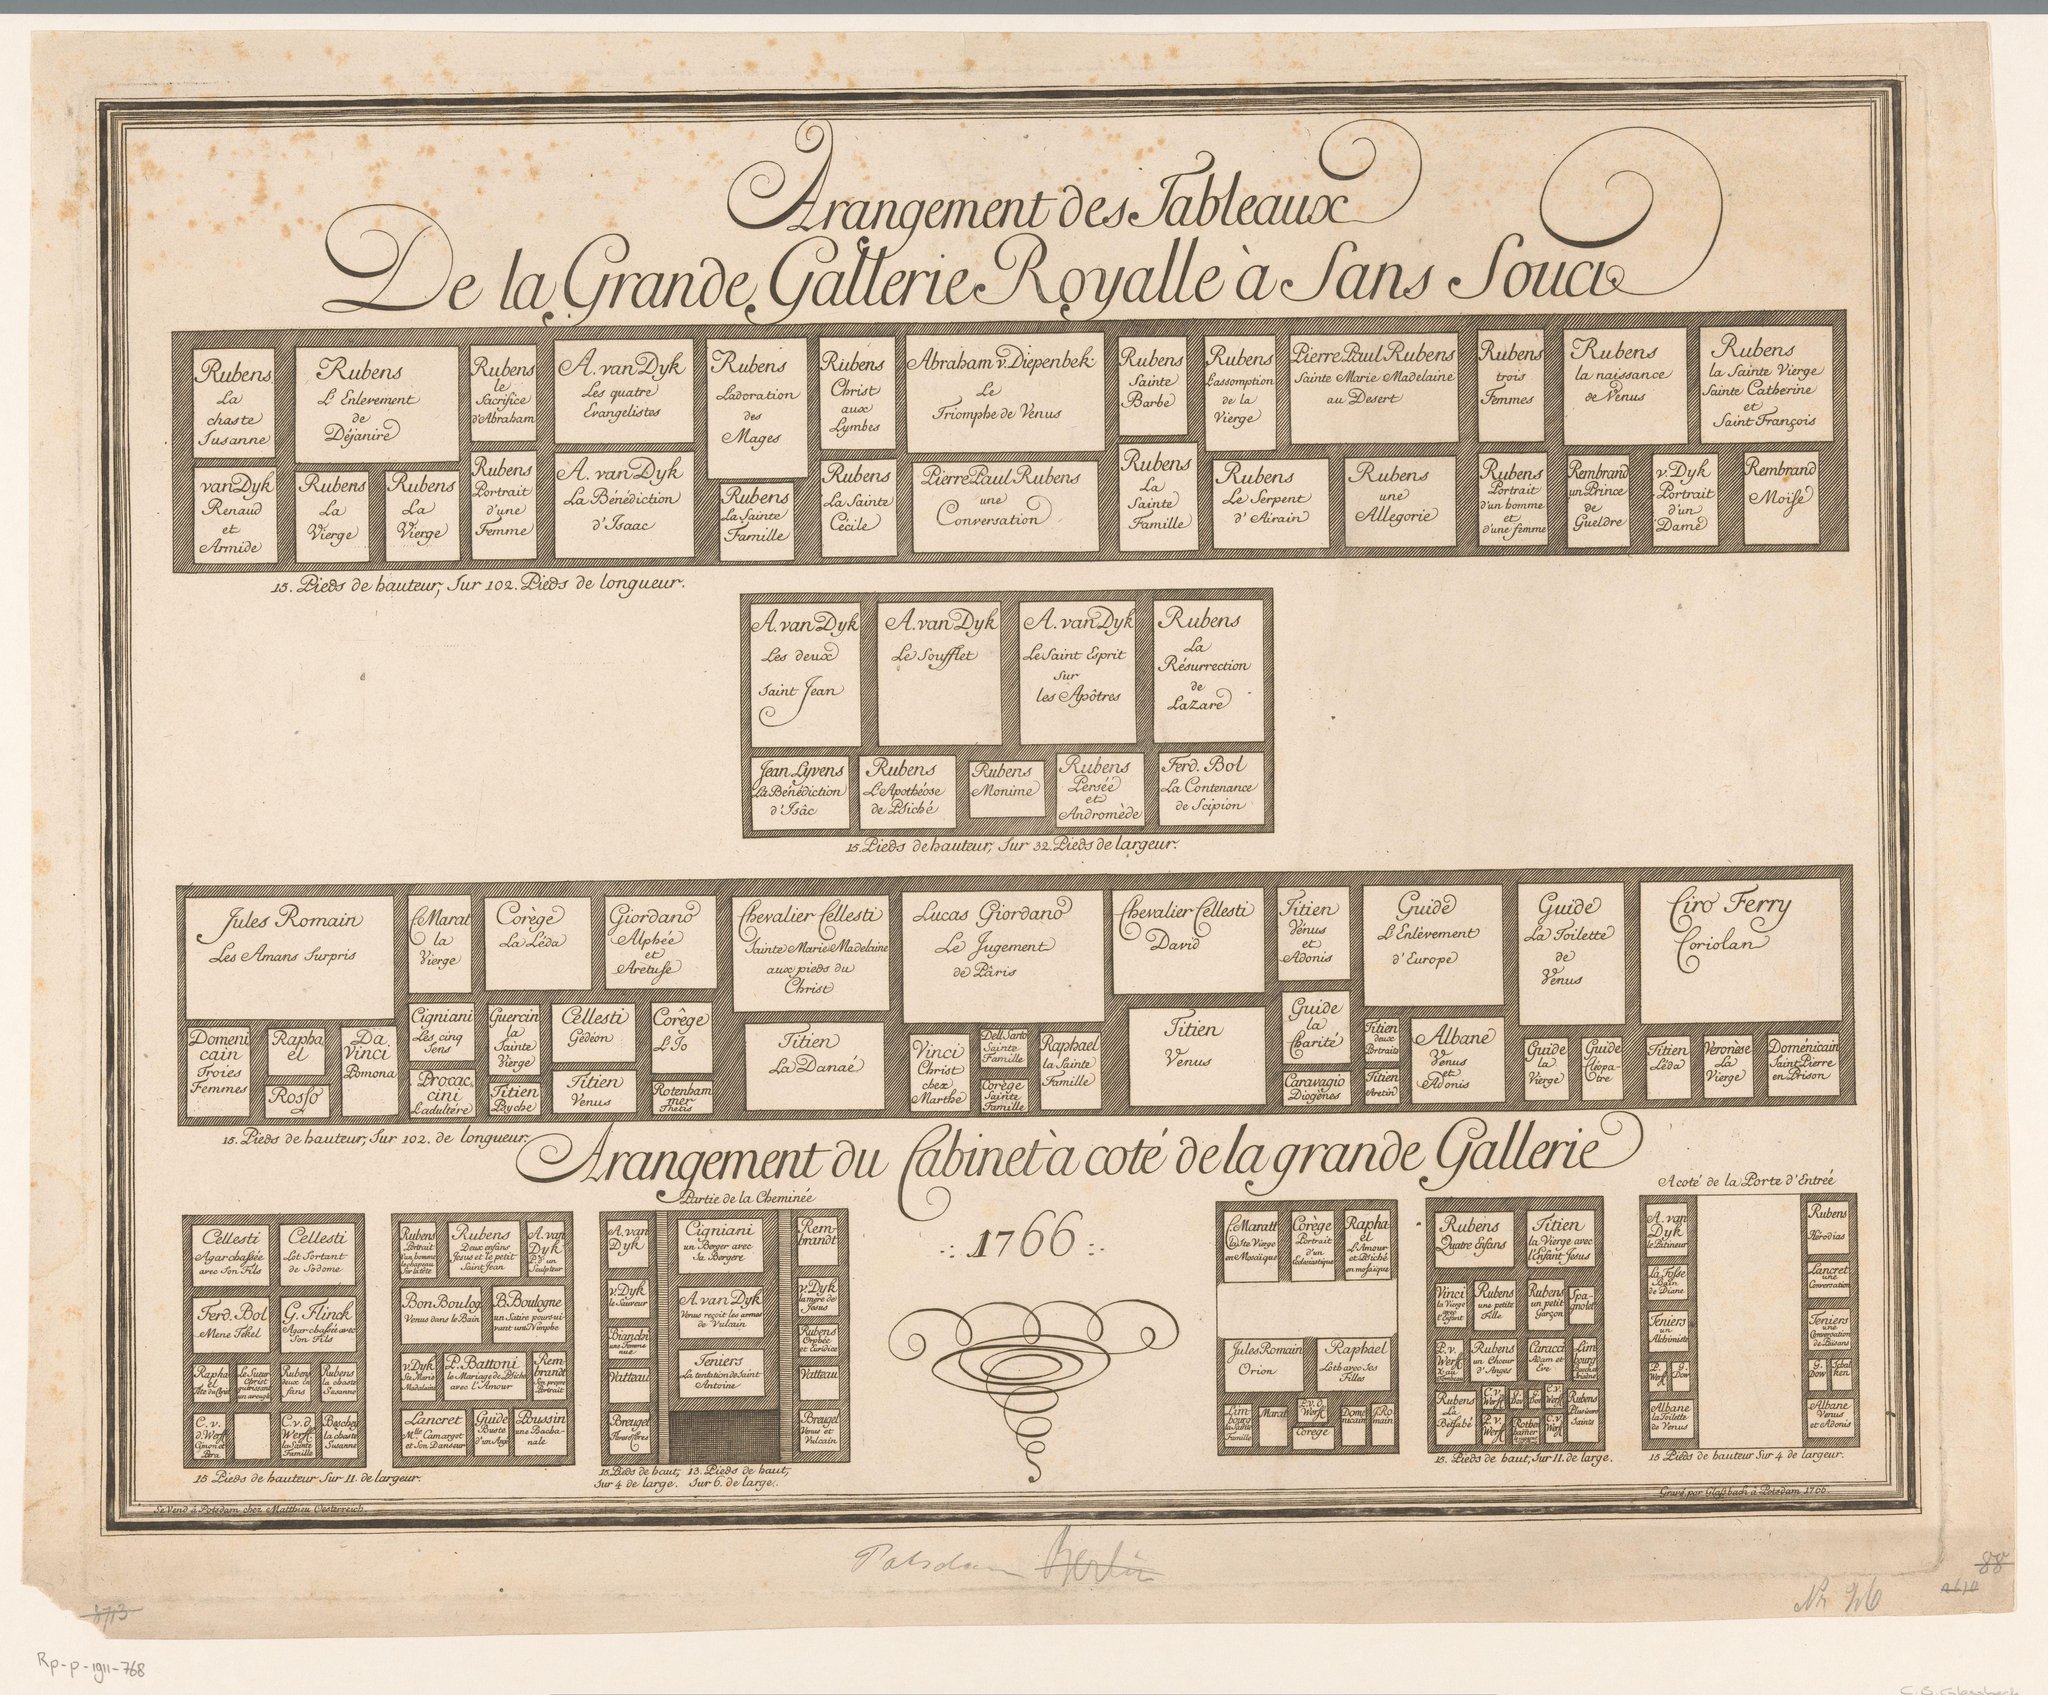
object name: print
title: Arangement des Tableaux de la grande Gallerie royale de Sans Souci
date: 1766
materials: paper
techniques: etching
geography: potsdam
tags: collection, exhibition, show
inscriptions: collector's mark: Lugt 2228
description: Plattegrond met de schilderijen opstelling voor de 1766 expositie in de koninklijke galerie van Sanssouci, te Potsdam. In de negen kamers zijn schilderijen opgesteld van grootmeesters als Anthony van Dyck, Peter Paul Rubens, Titiaan en vele anderen.